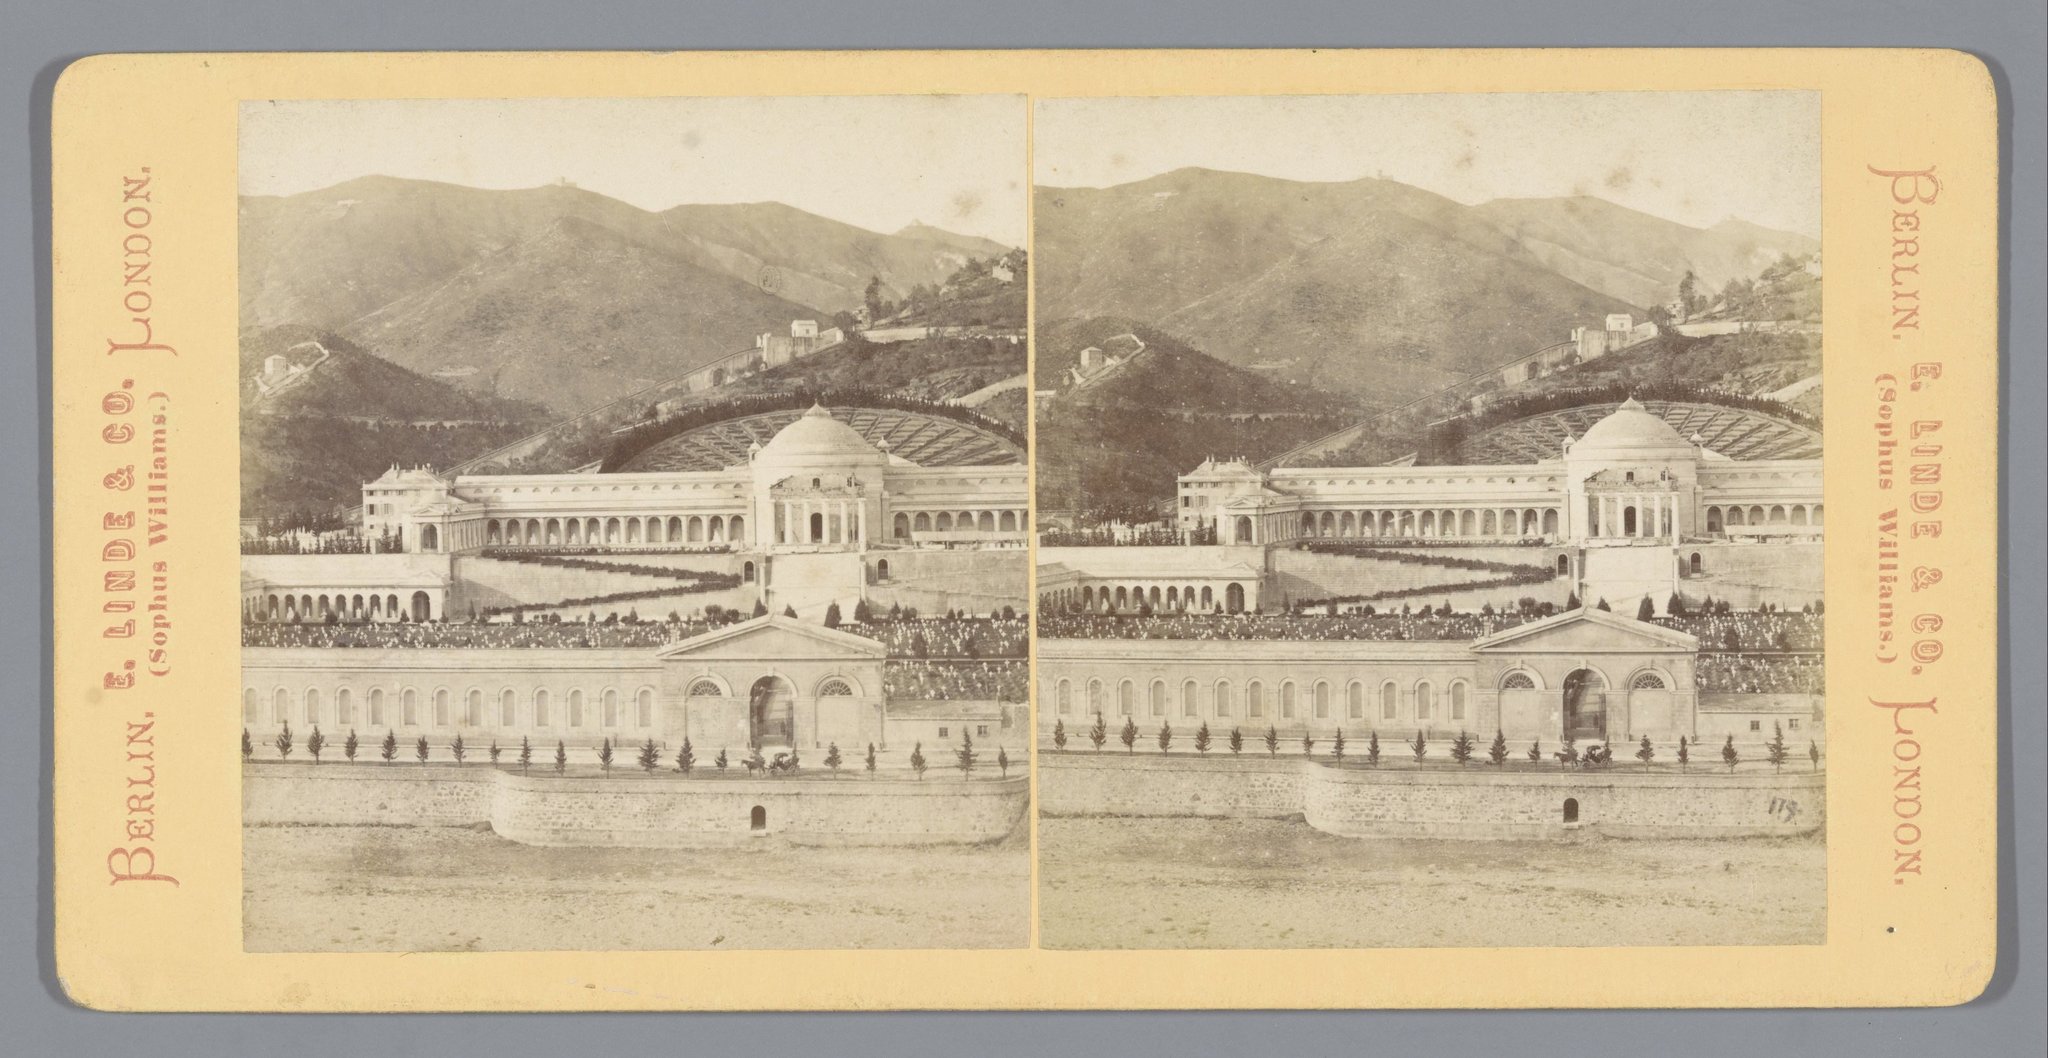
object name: stereograph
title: Gezicht op het Camposanto te Genua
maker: alfredo noack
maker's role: fotograaf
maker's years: 1833-1895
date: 1870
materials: cardboard, photographic support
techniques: albumen print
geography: genoa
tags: churchyard, cemetery, façade (of house or building)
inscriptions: inscription: ‘Genua Das Campo Santo aus der Vogel-Perspective’, name: ‘E. LINDE & CO. (Sophus Williams.) BERLIN. LONDON.’, number: ‘No 179.’